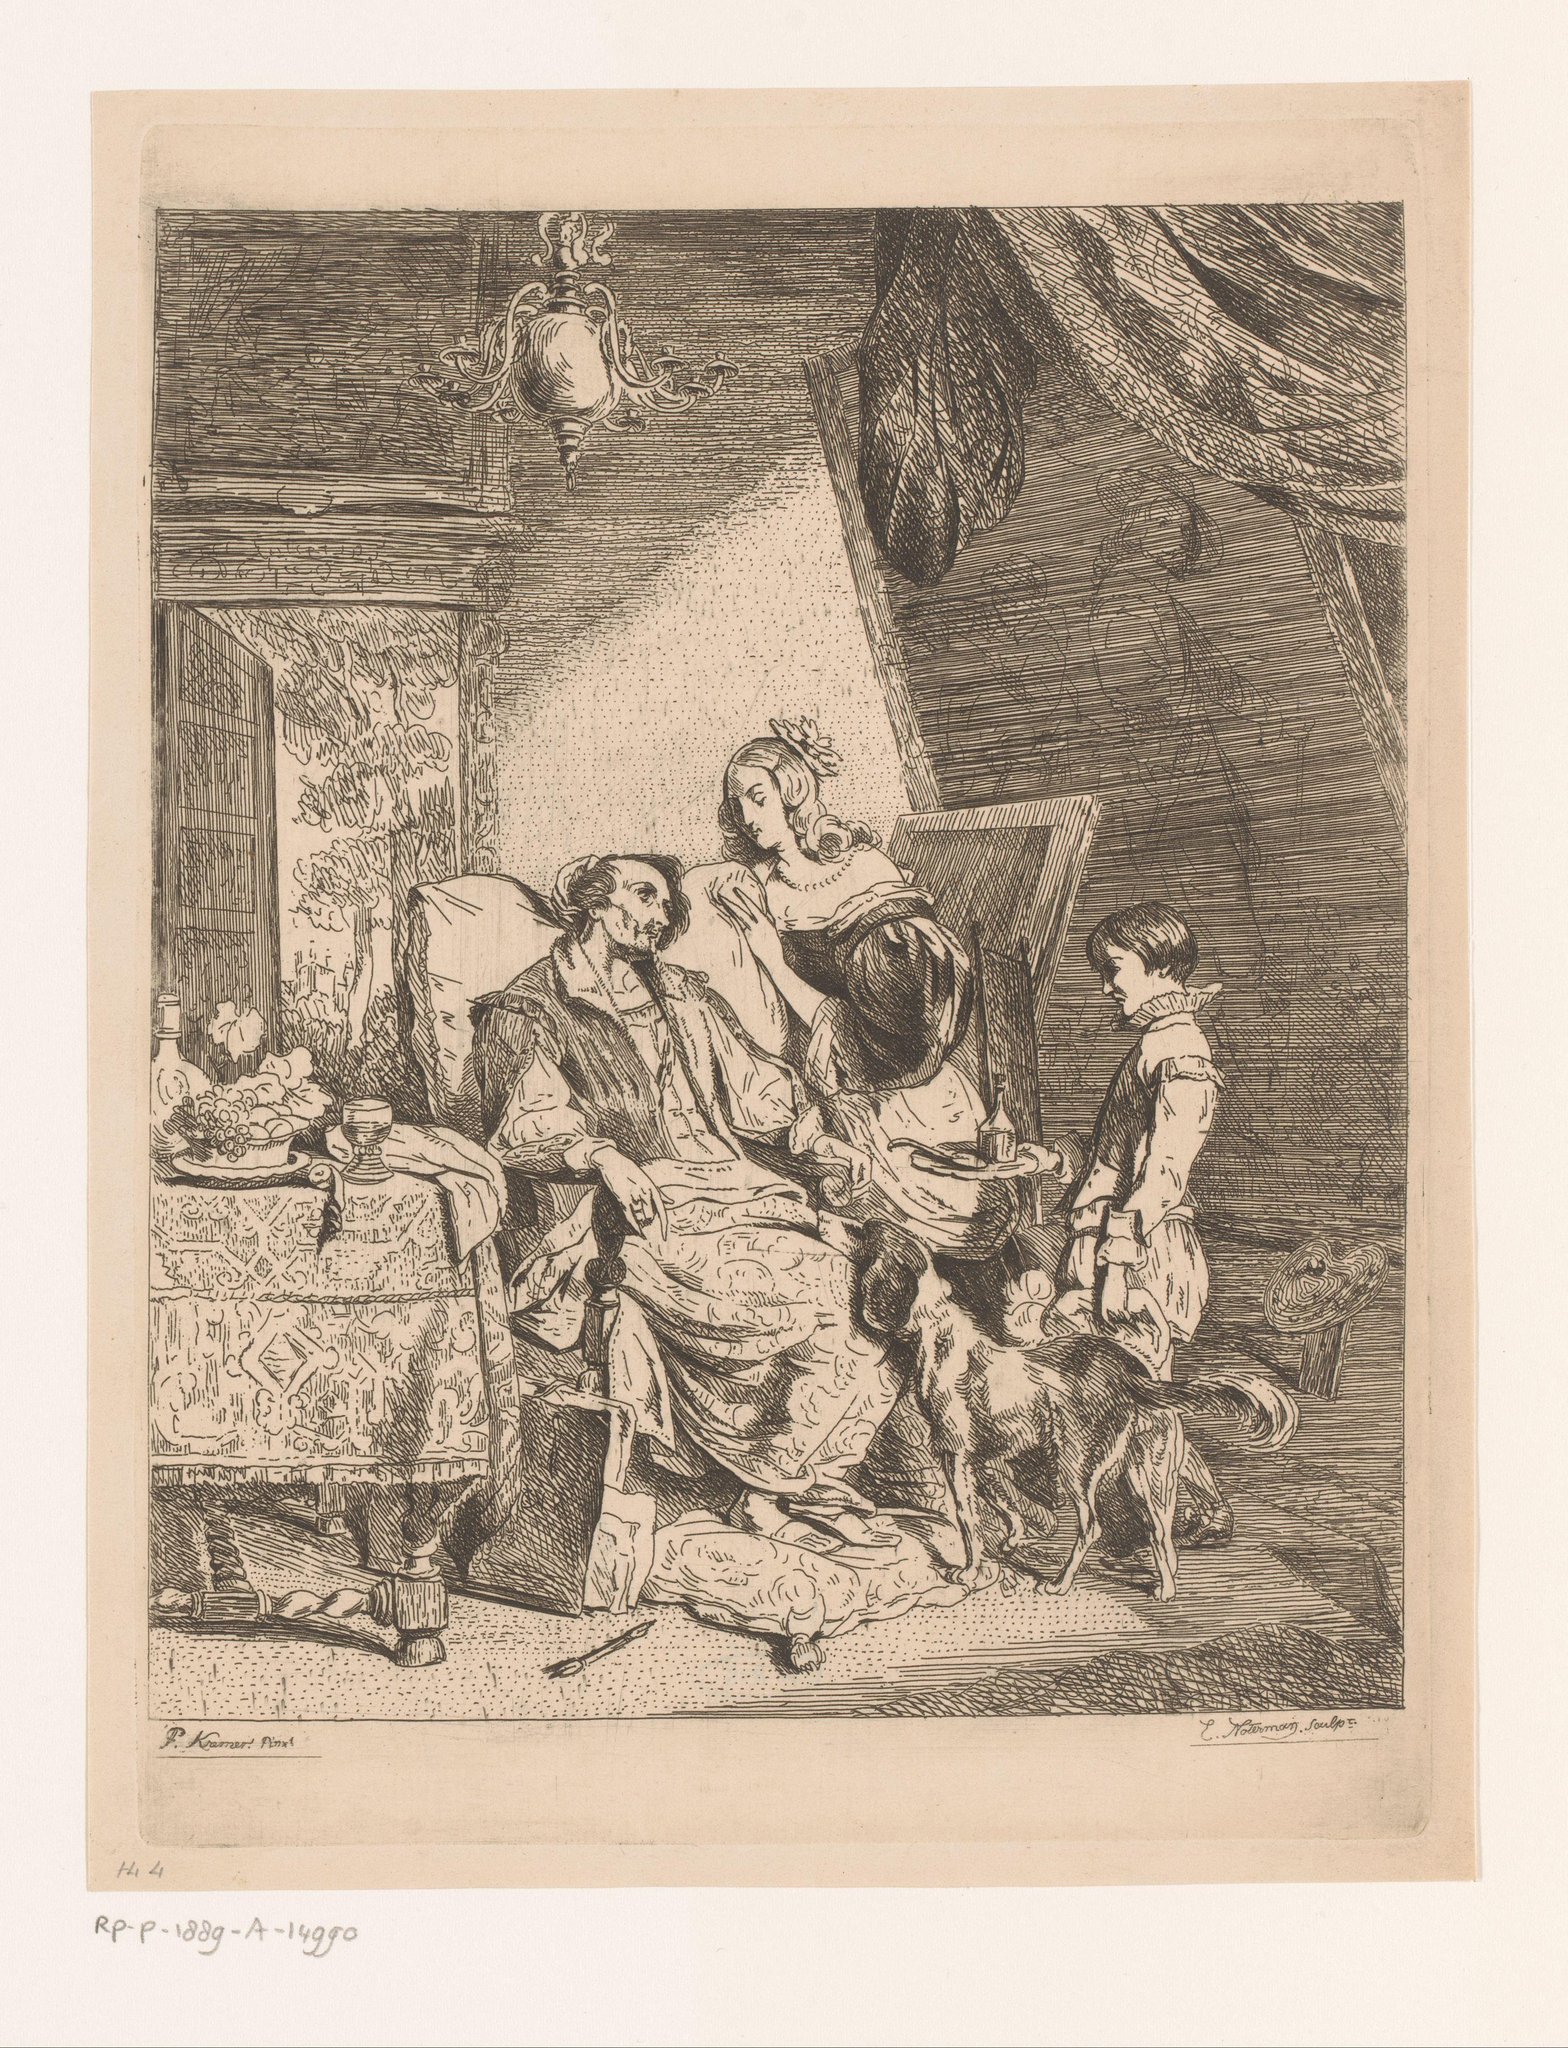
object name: print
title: Anthony van Dyck op zijn sterfbed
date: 1818-1863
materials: paper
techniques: etching, intaglio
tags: antwerp, london, painter, print maker, draughtsman, anthony van dyck, deathbed, interior ~ representation of a building, medicament, medicine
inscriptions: collector's mark: Lugt 2228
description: Van Dyck zit in een grote stoel bij een tafel met om zich heen een vrouw, jongen met een blad met medicijnen en een hond.